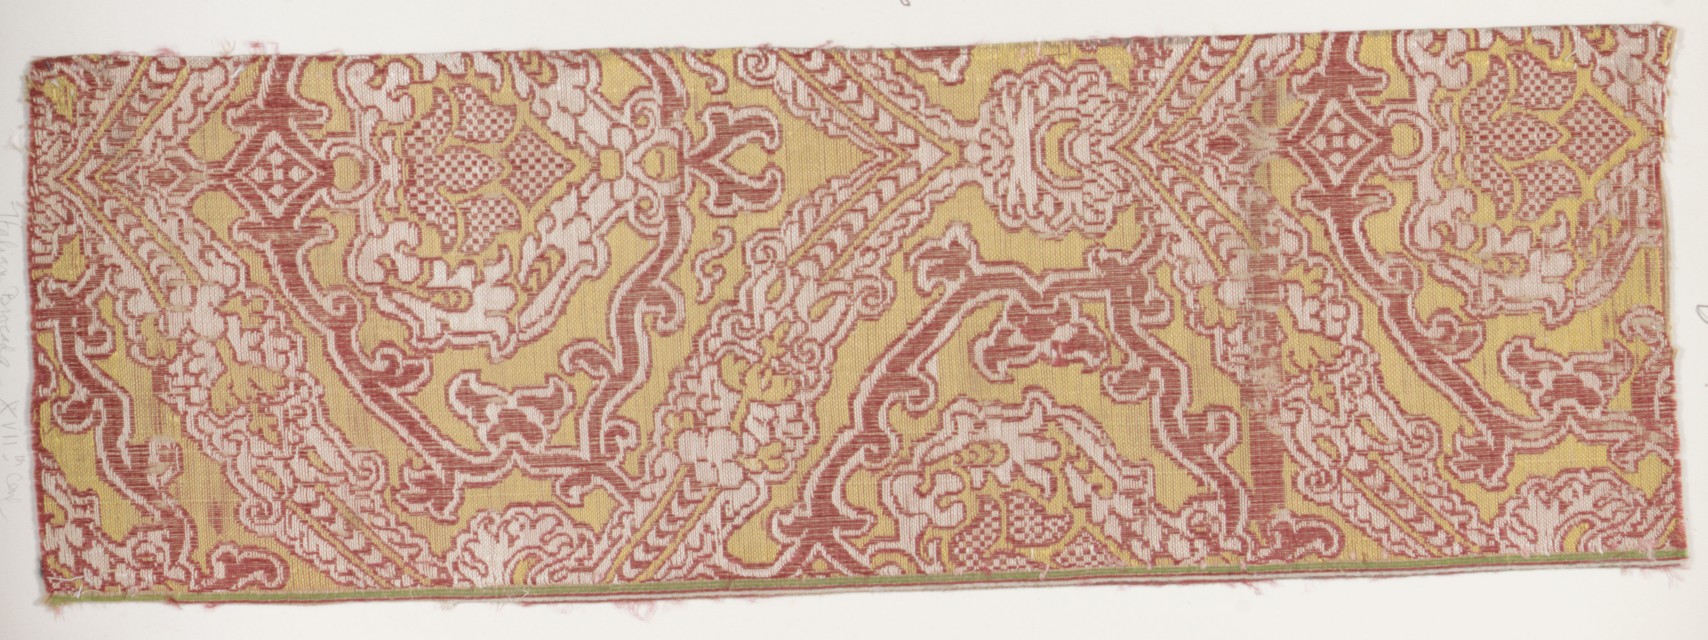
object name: fragment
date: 1601-1700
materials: silk